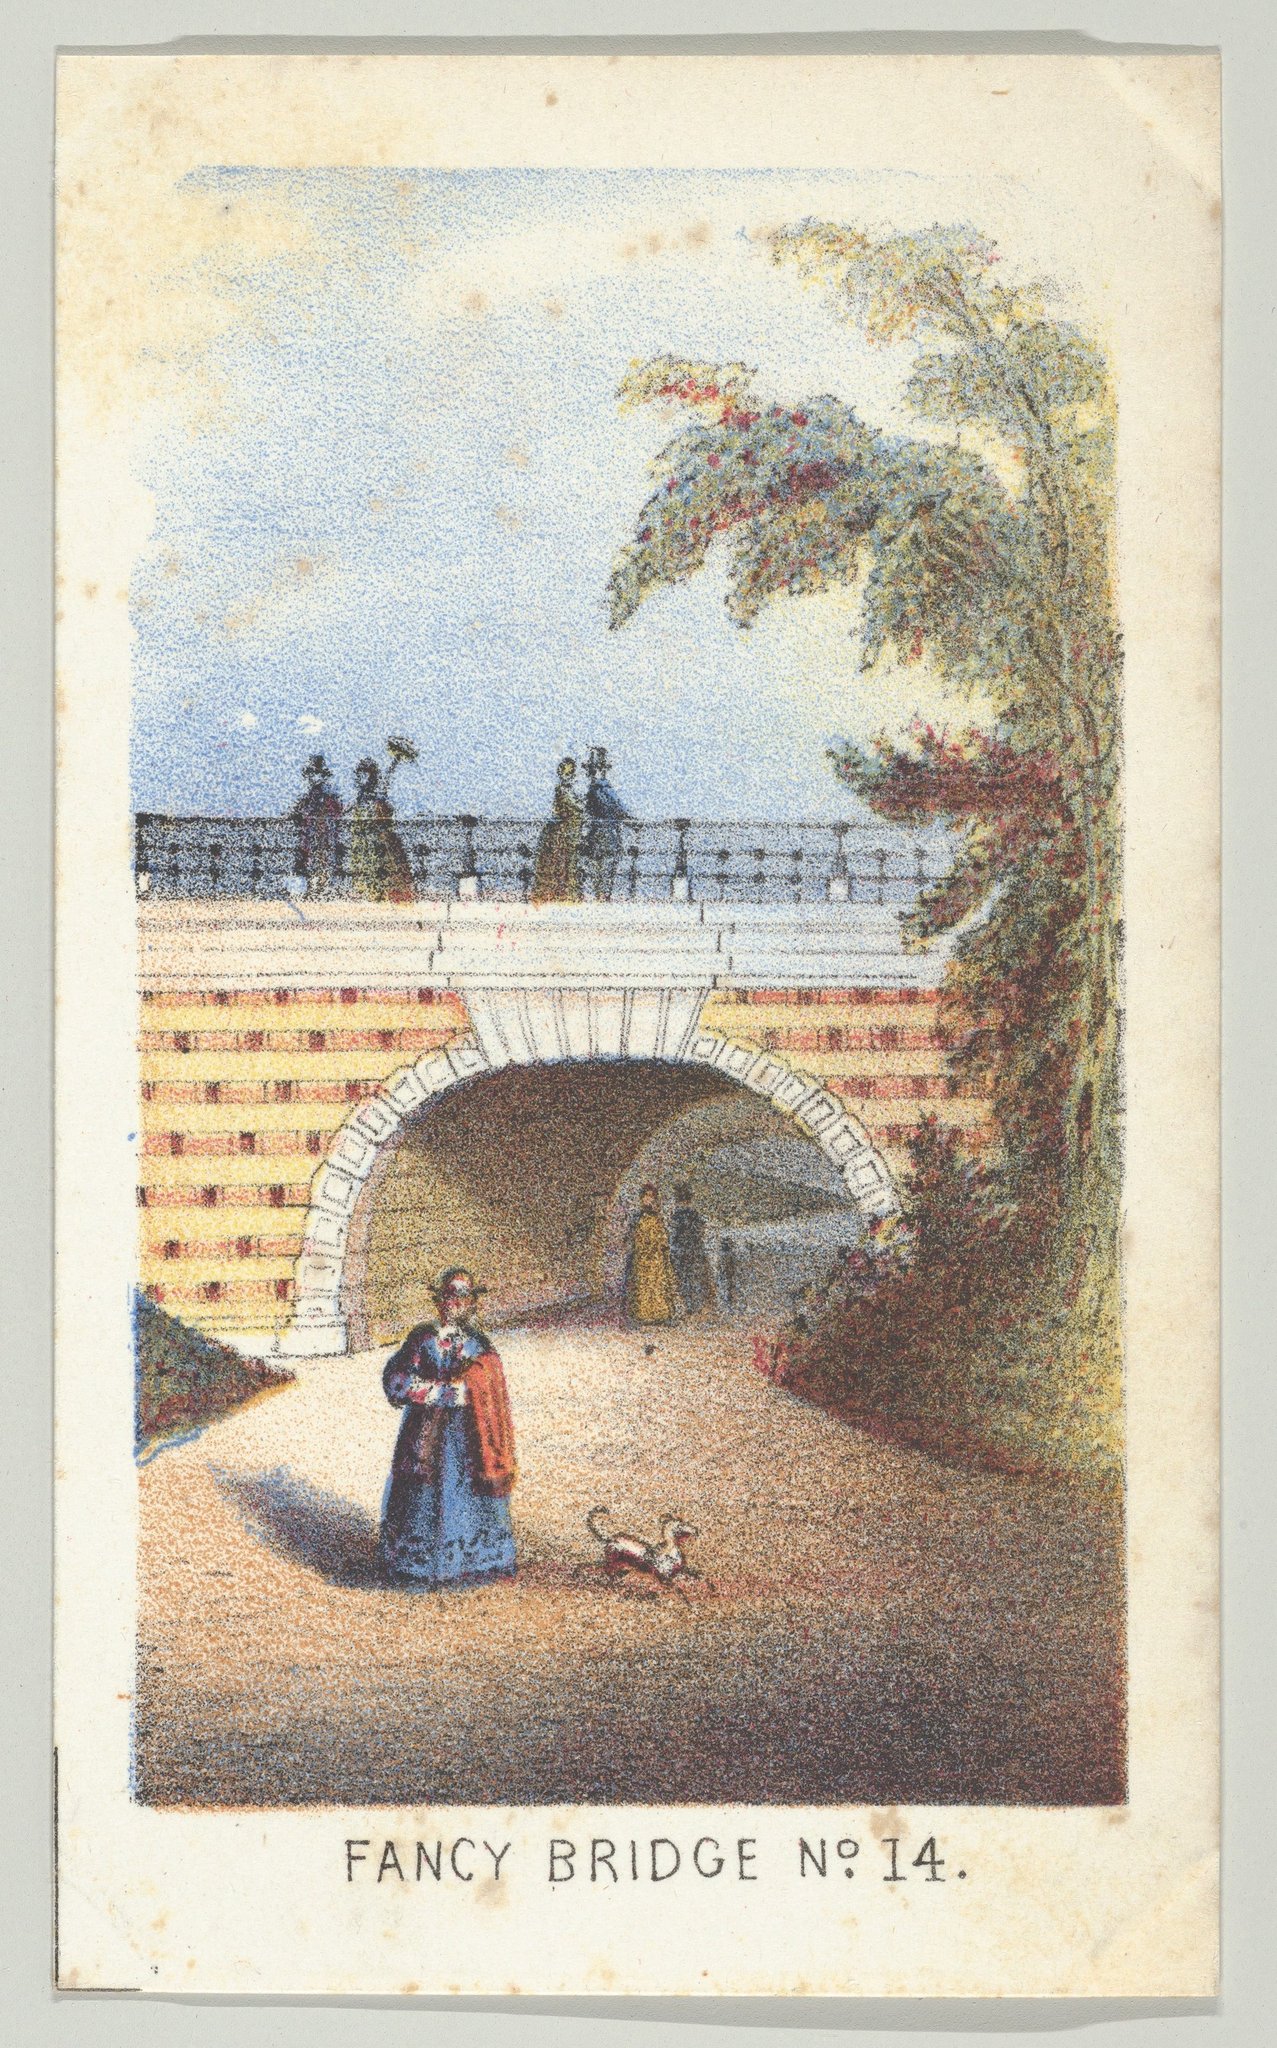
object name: print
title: Fancy Bridge No. 14, from the series, Views in Central Park, New York, Part 3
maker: louis prang & co.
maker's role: publisher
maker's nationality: american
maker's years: 1800-1950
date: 1864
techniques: lithograph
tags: bridges,parks